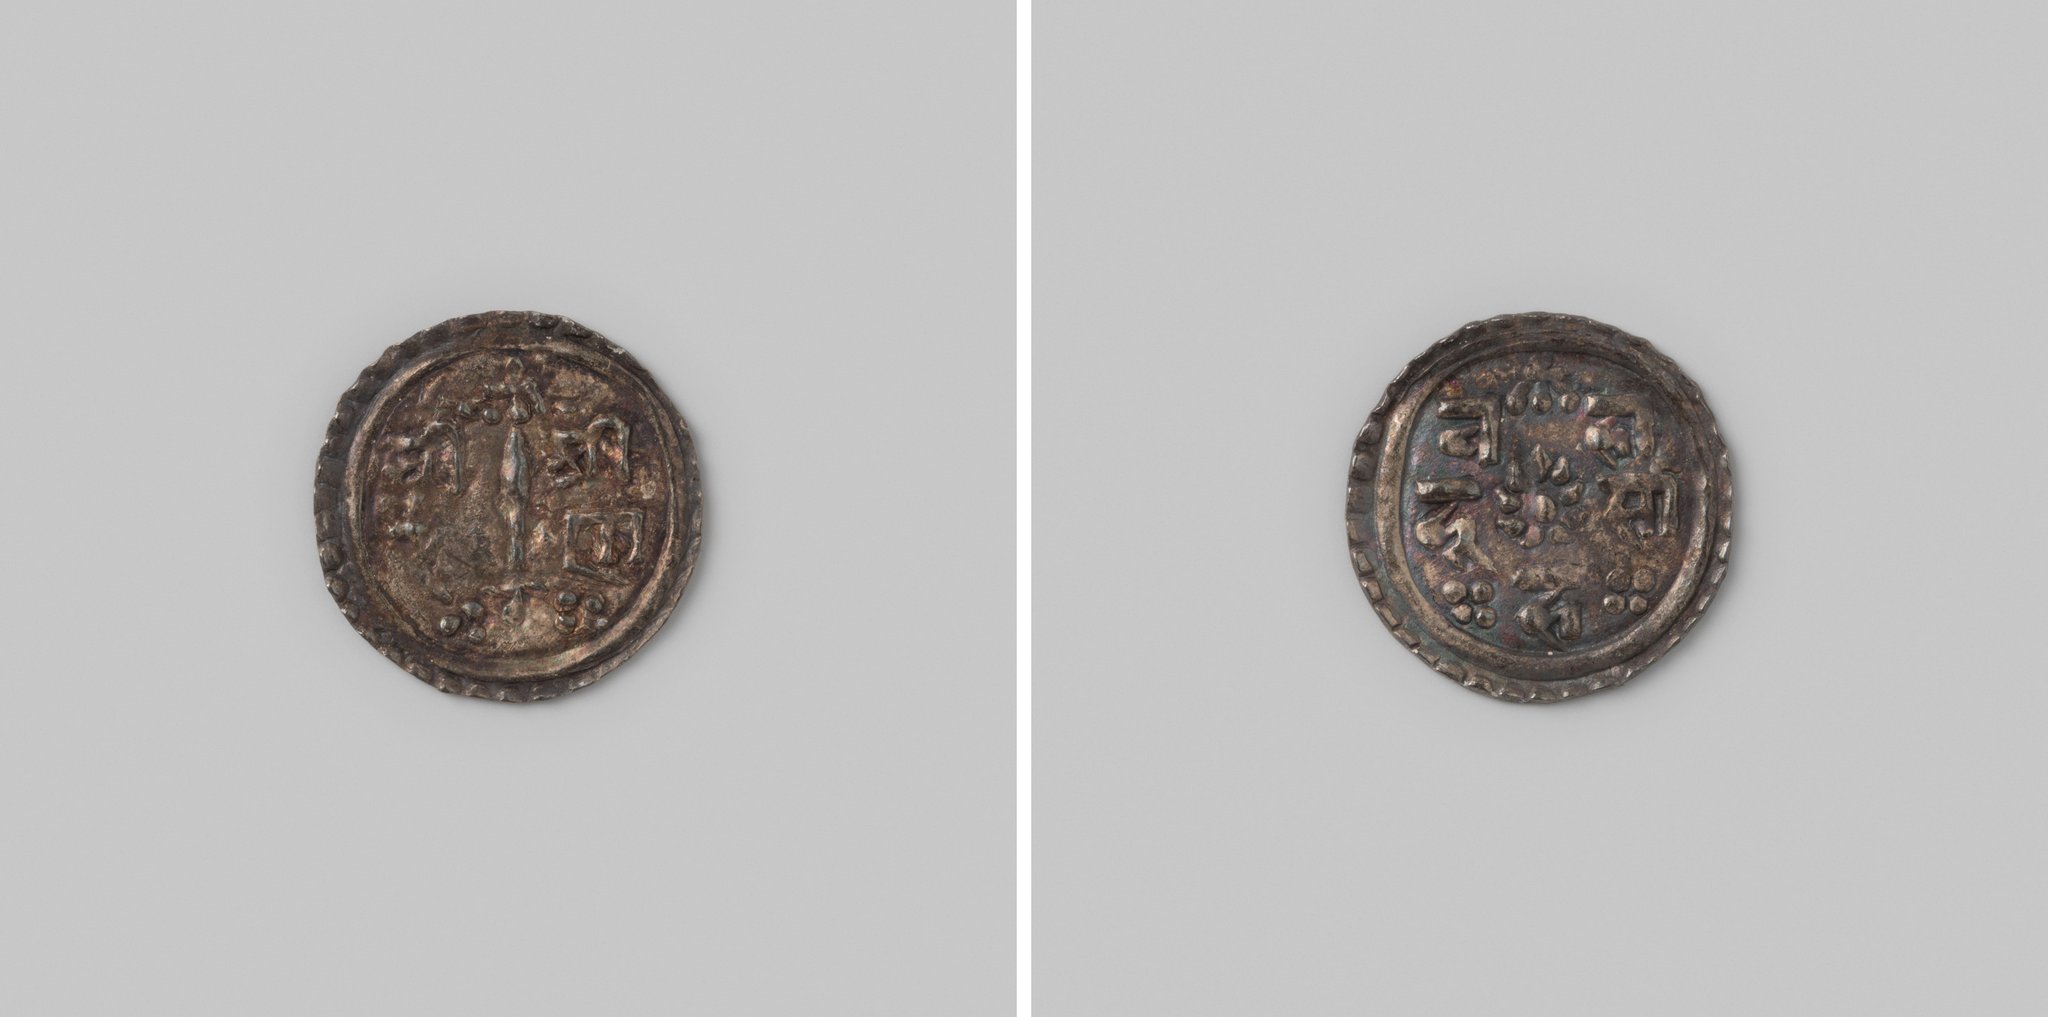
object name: coin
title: Nepal, 1/16 mohar, 1780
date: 1780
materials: silver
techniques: striking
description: Zilveren munt. Voorzijde: rondom figuur tekens in Nagari-schrift. Keerzijde: rondom figuur tekens in Nagari-schrift. Jaartal onderaan. Gladde rand.